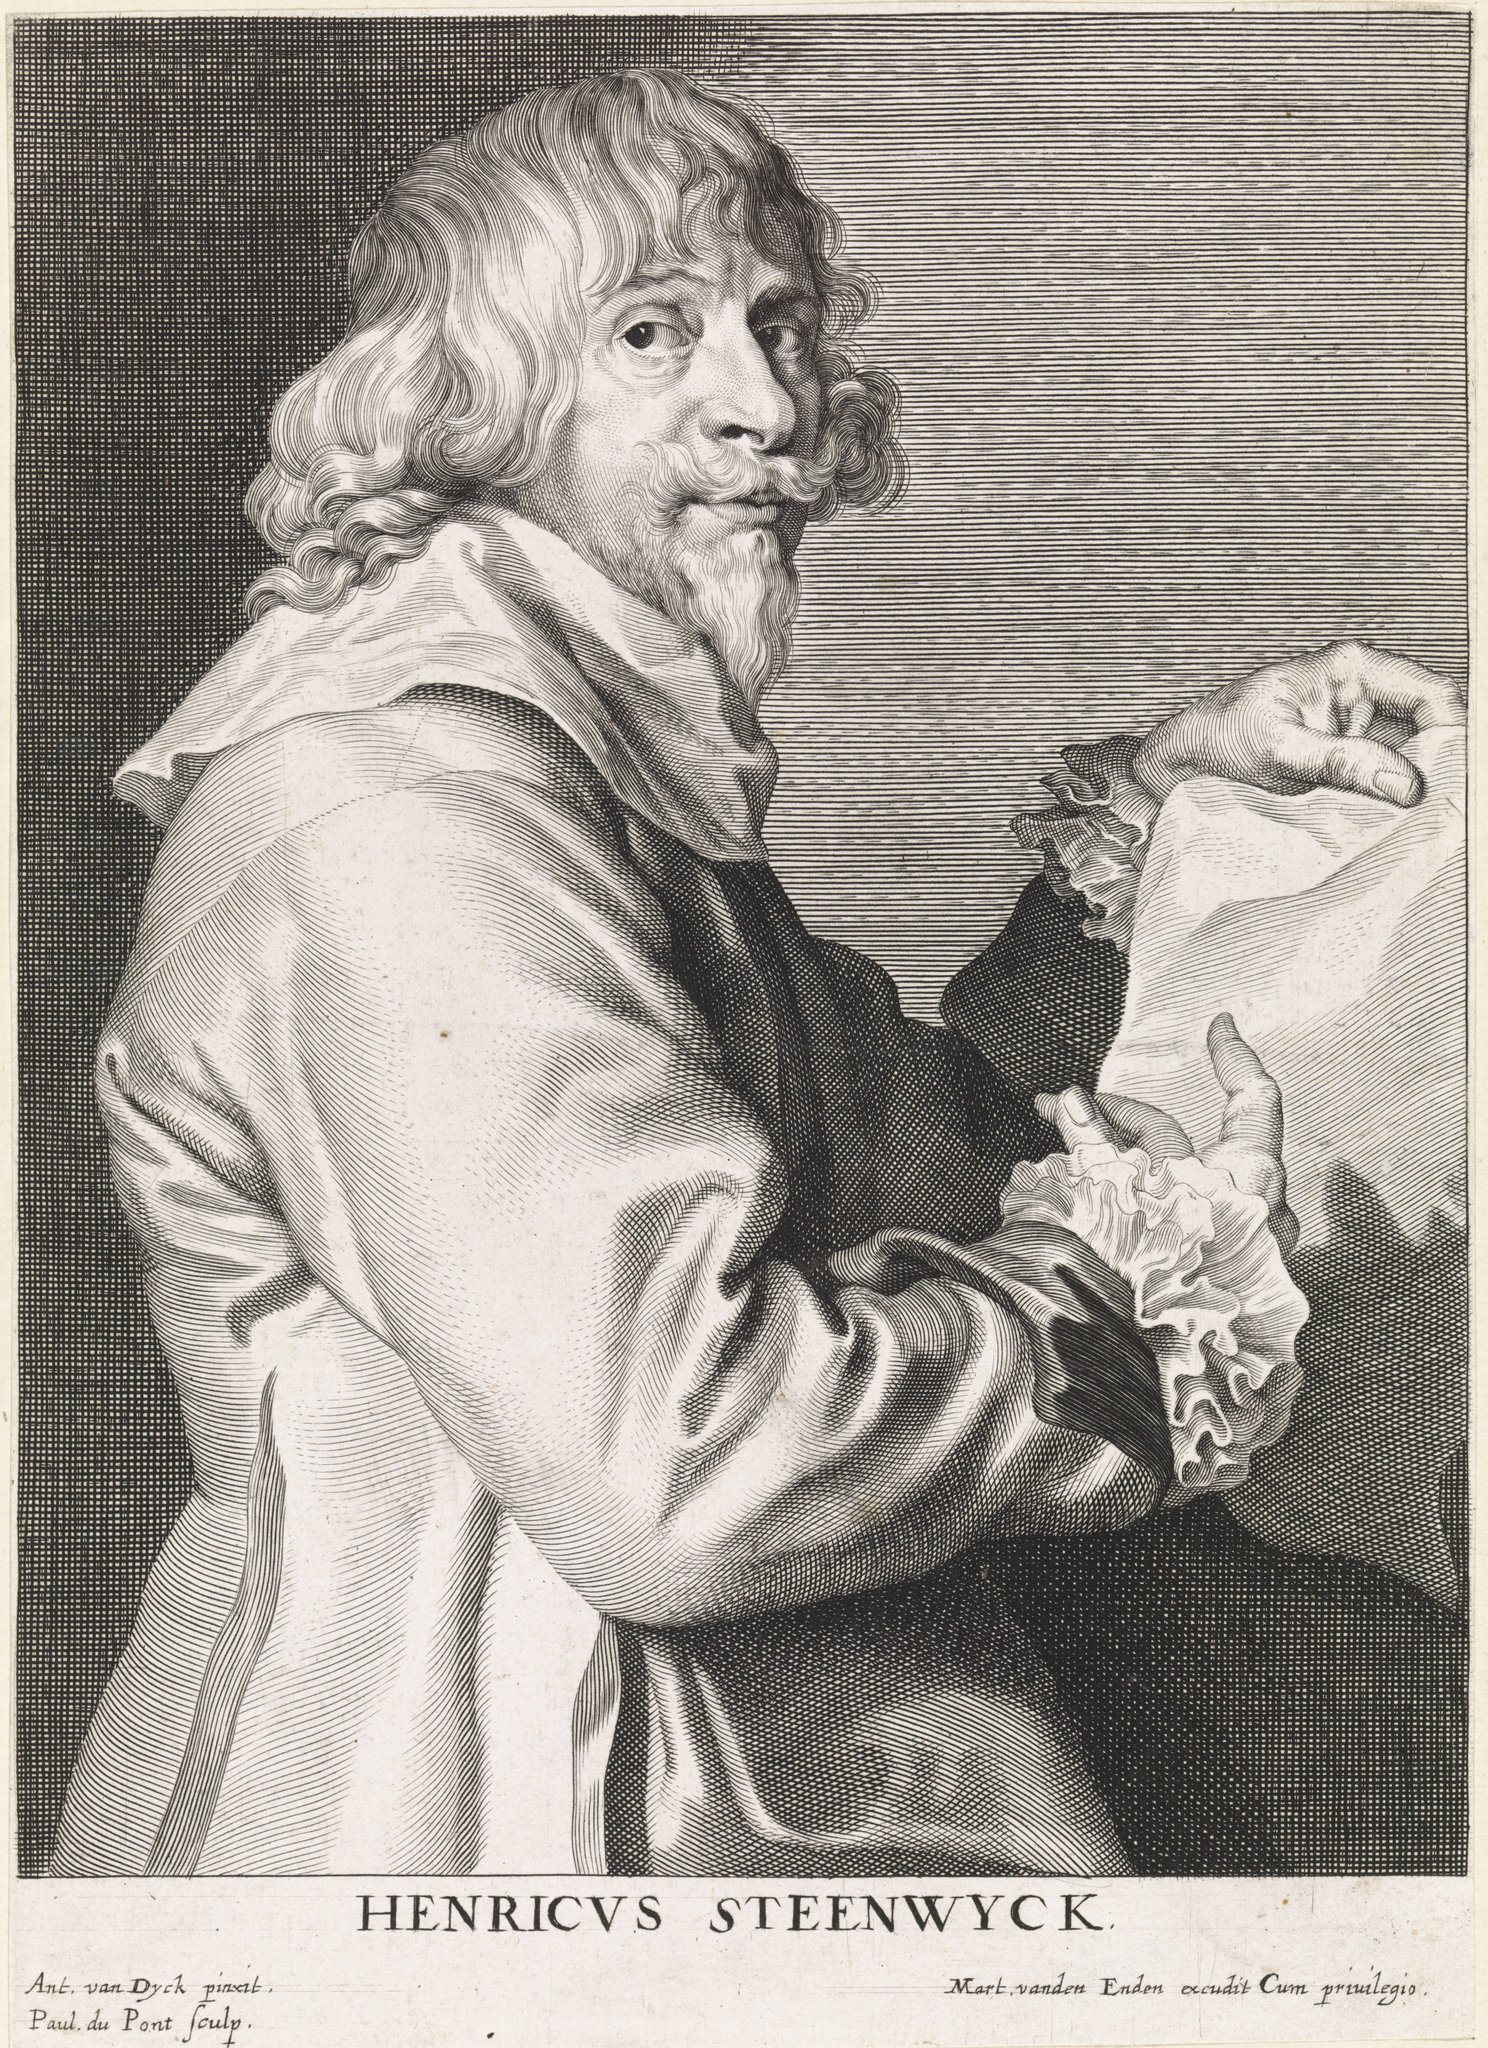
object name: print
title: Portret van de schilder Hendrik van Steenwijck (II)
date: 1616-1657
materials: paper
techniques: engraving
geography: antwerp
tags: antwerp, painter, hendrik van steenwijck (ii), portrait, self-portrait of painter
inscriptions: collector's mark: Lugt 240